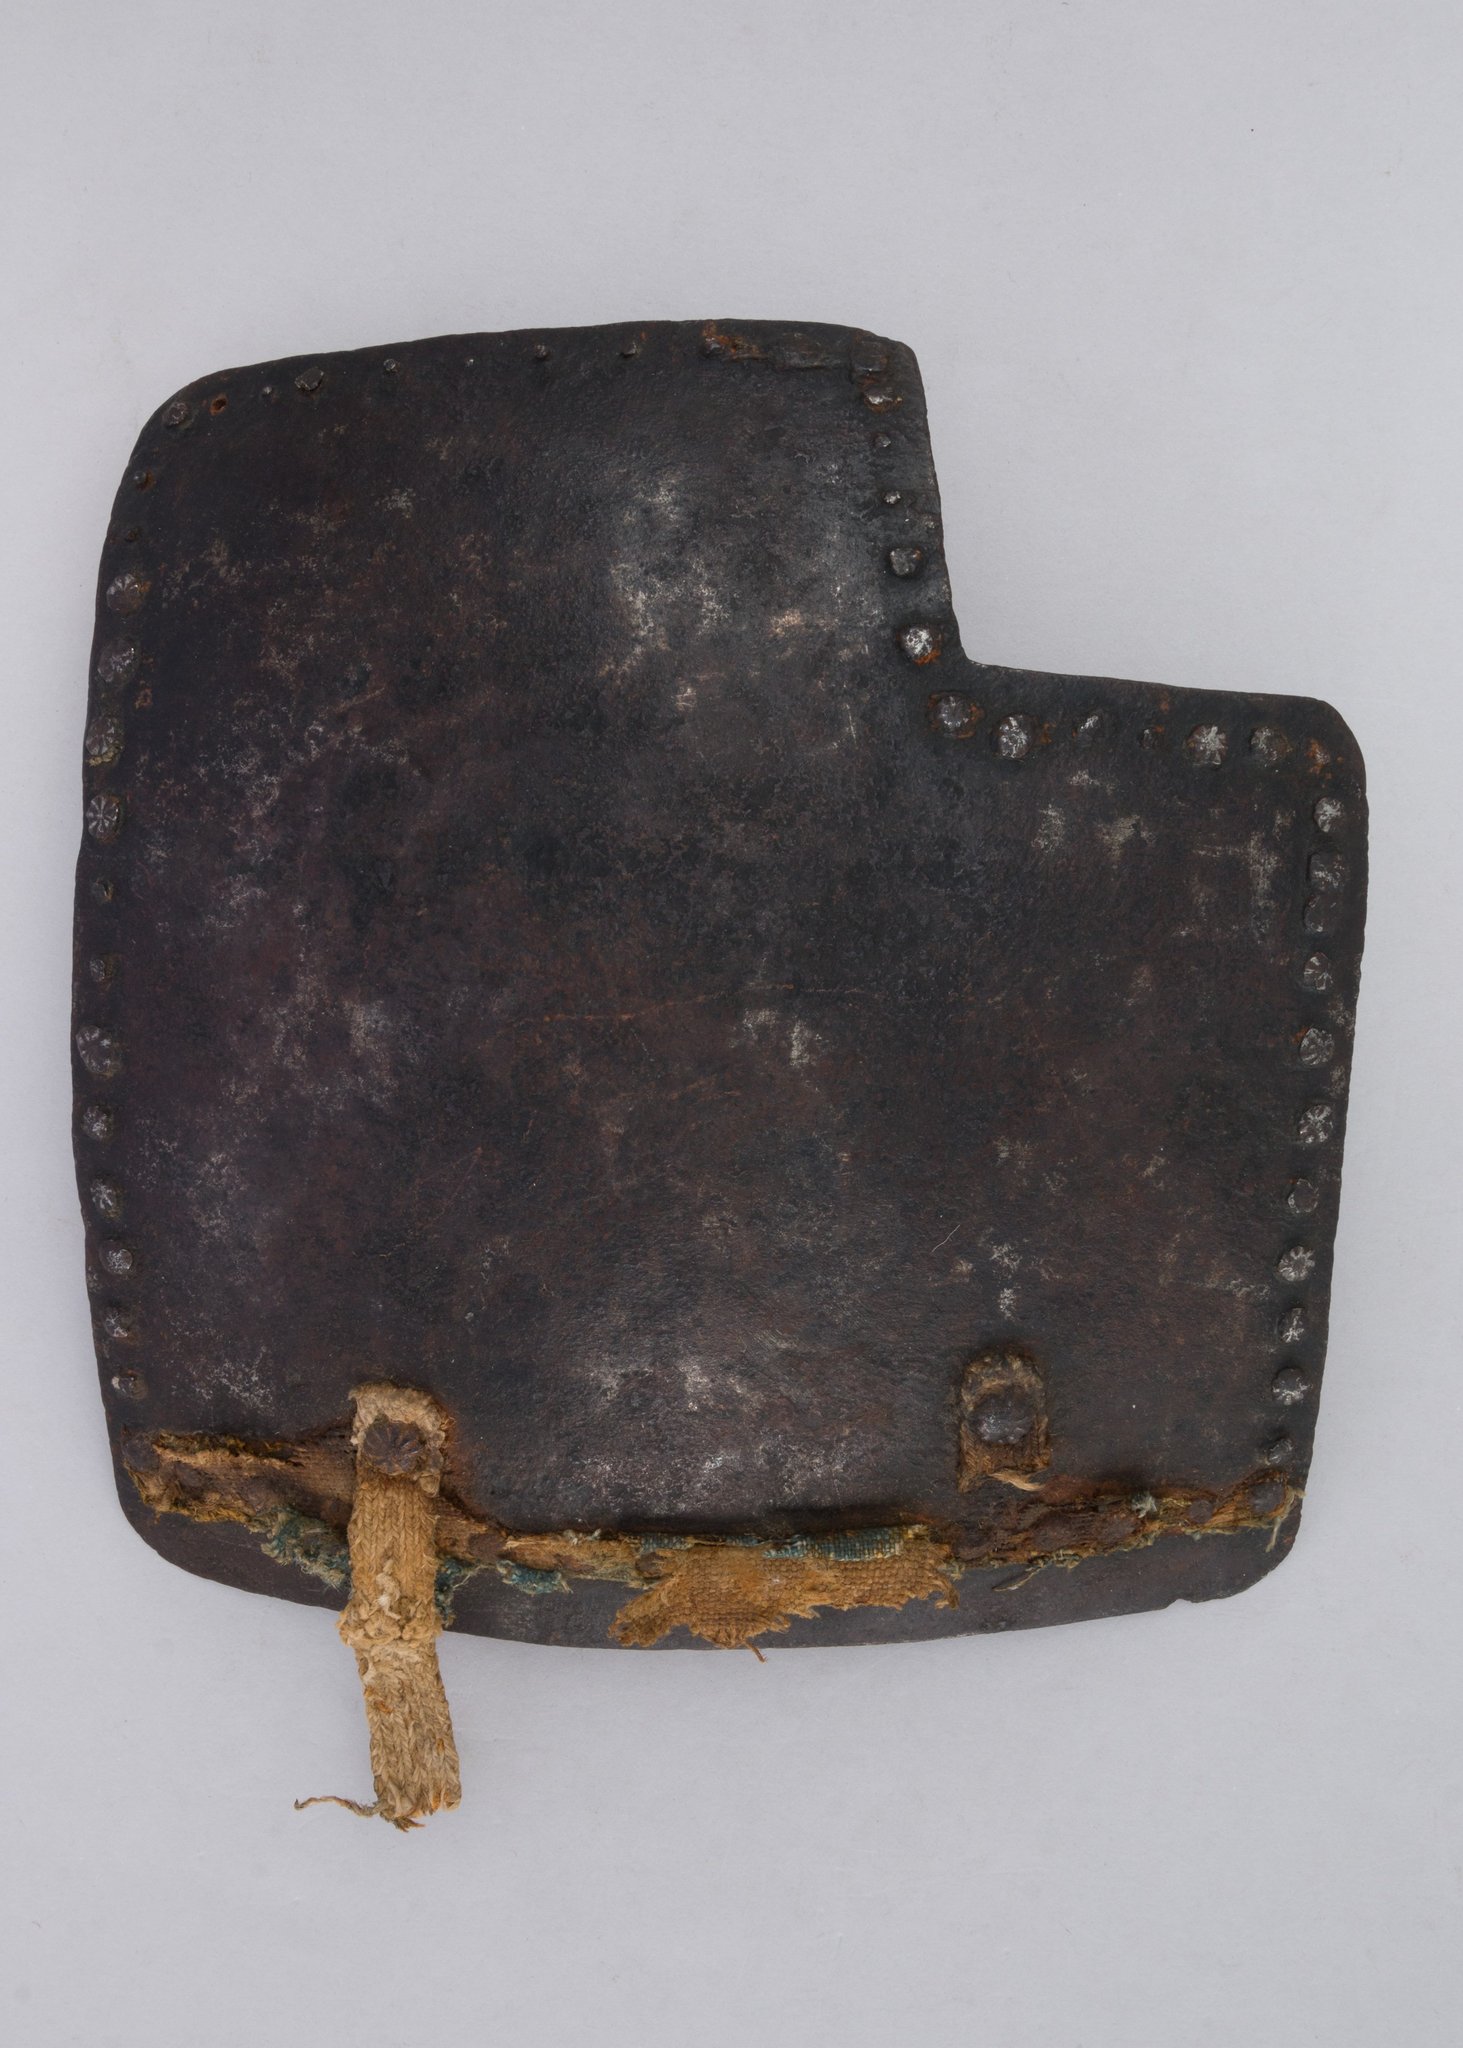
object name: right breastplate from a brigandine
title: Right Half of Brigandine Breastplate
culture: italian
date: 1400-1450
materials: steel, textile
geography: italy